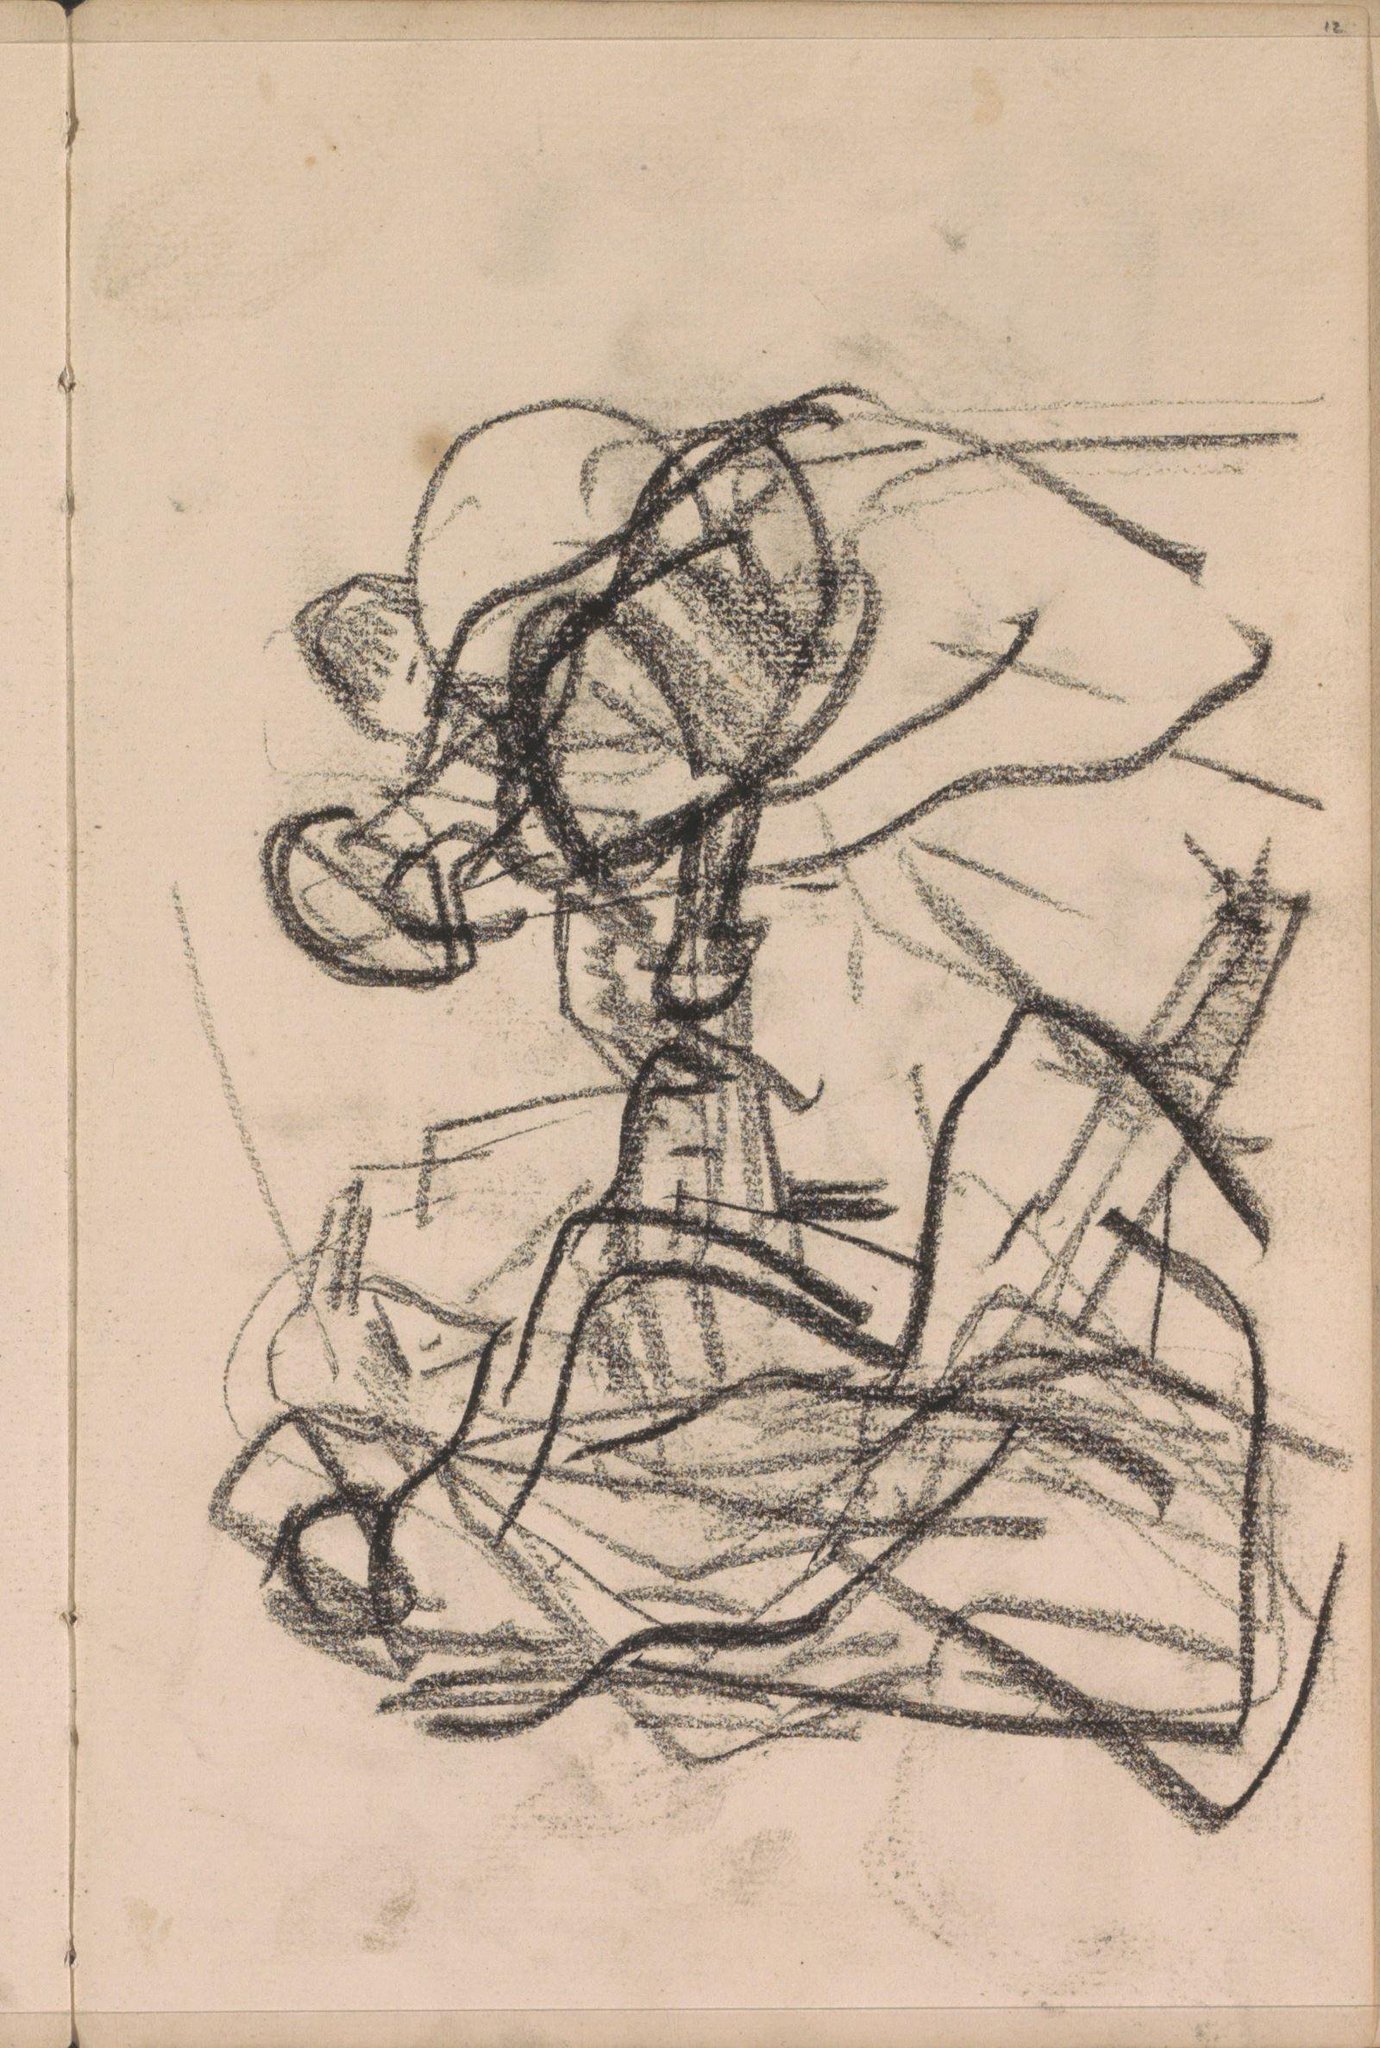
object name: sketchbook leaf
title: Figuren aan een tafel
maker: george hendrik breitner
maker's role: draughtsman, painter, print maker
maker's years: 1857-1923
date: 1883-1885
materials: chalk, paper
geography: the hague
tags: sitting figure, sitting figure - aa - female human figure, table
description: Pagina 12 uit een schetsboek met 18 bladen.